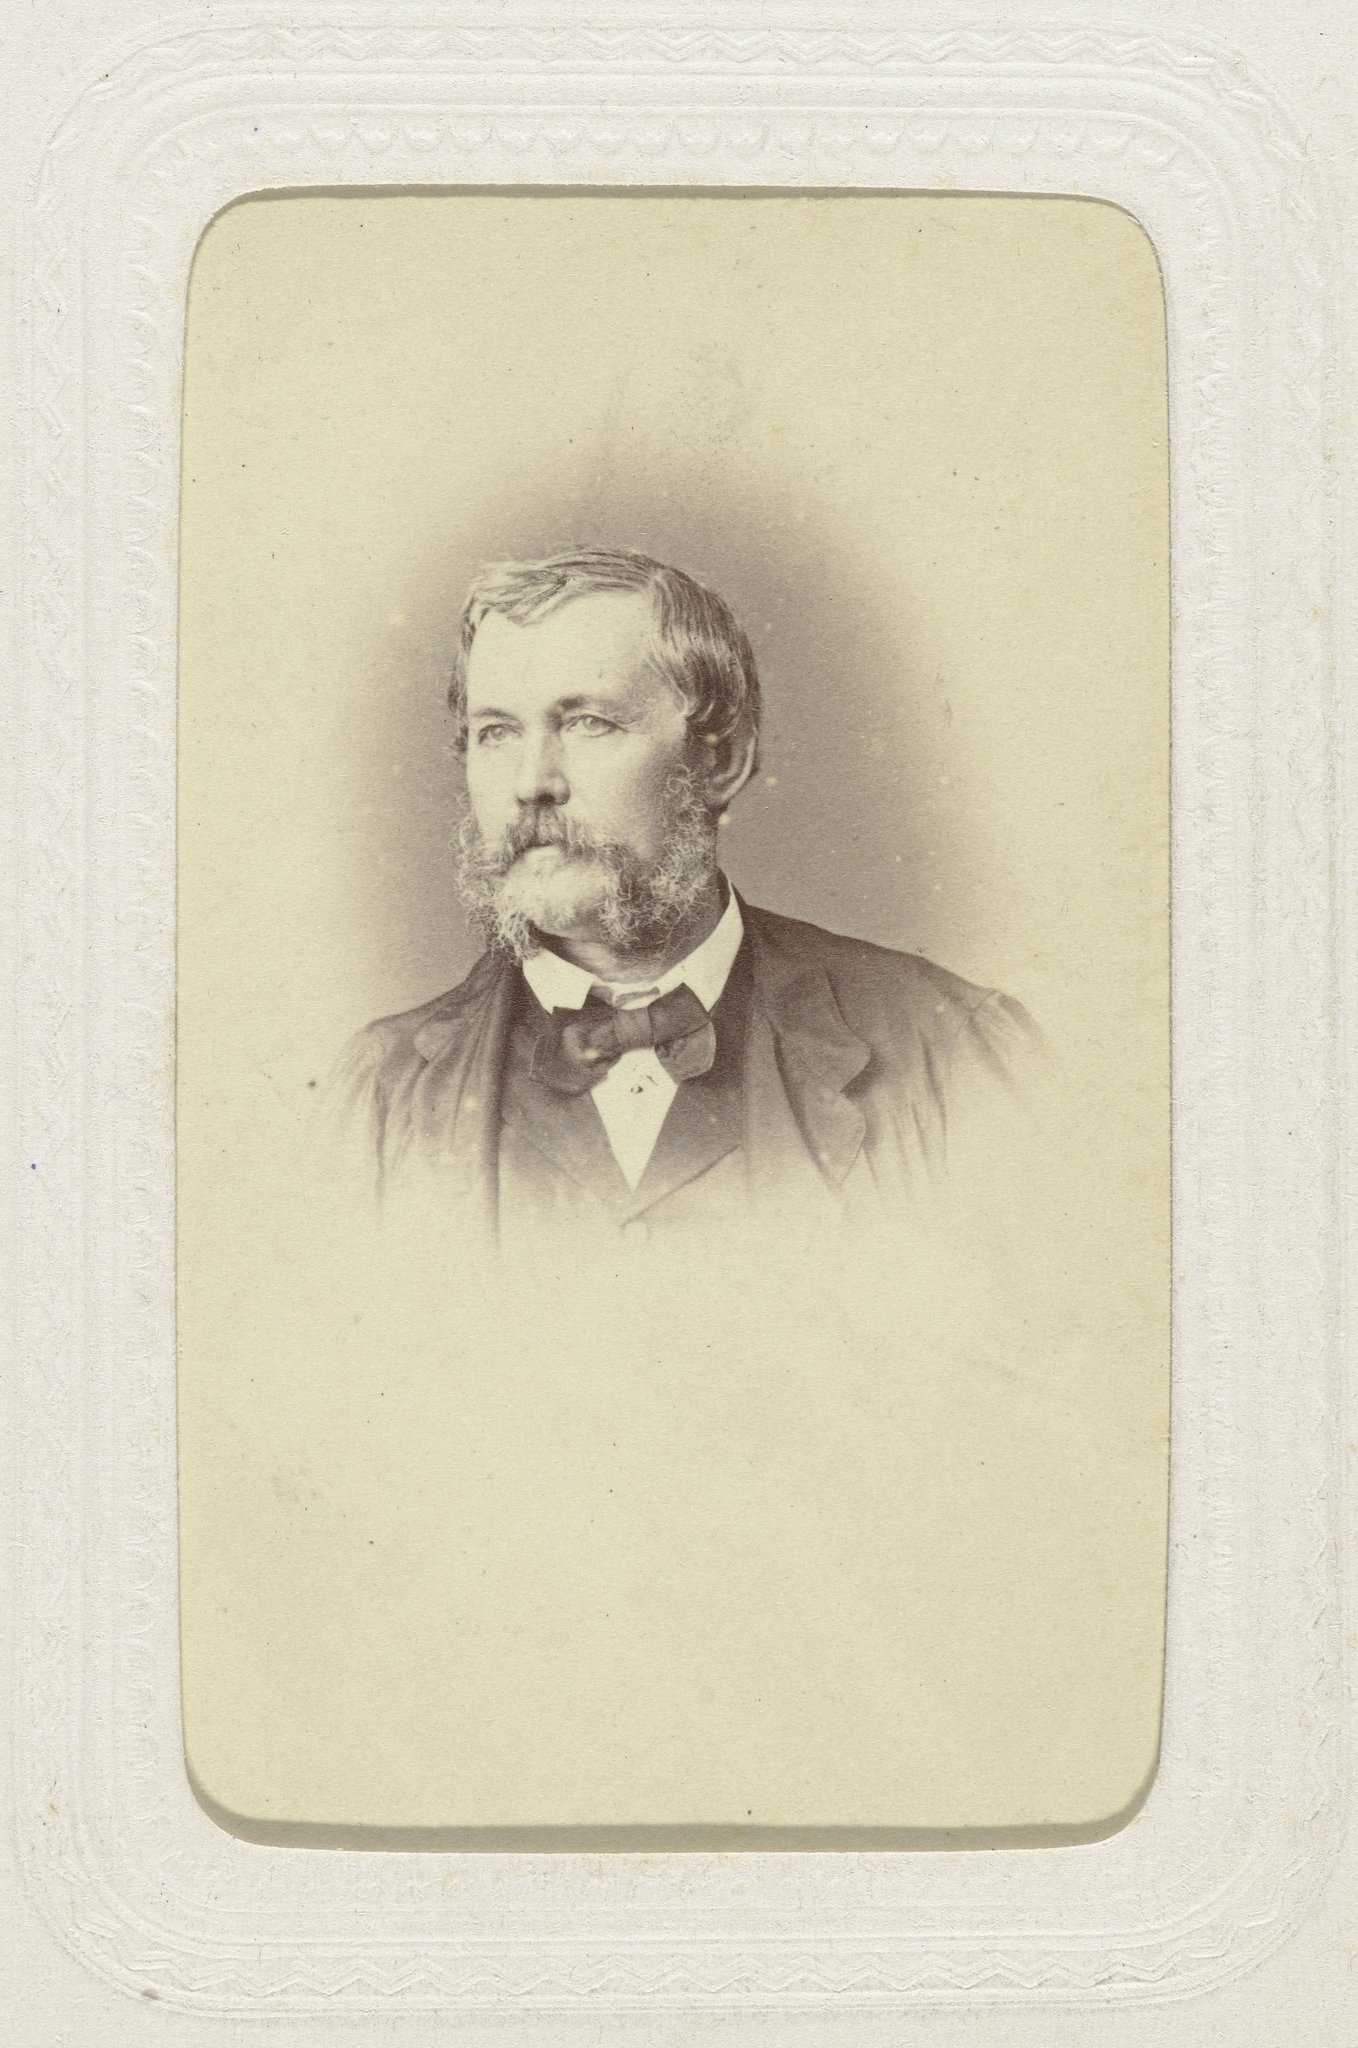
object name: carte de visite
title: Studioportret van een man met snor en een vlinderdas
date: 1863-1866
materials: cardboard, paper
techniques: albumen print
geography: istanbul